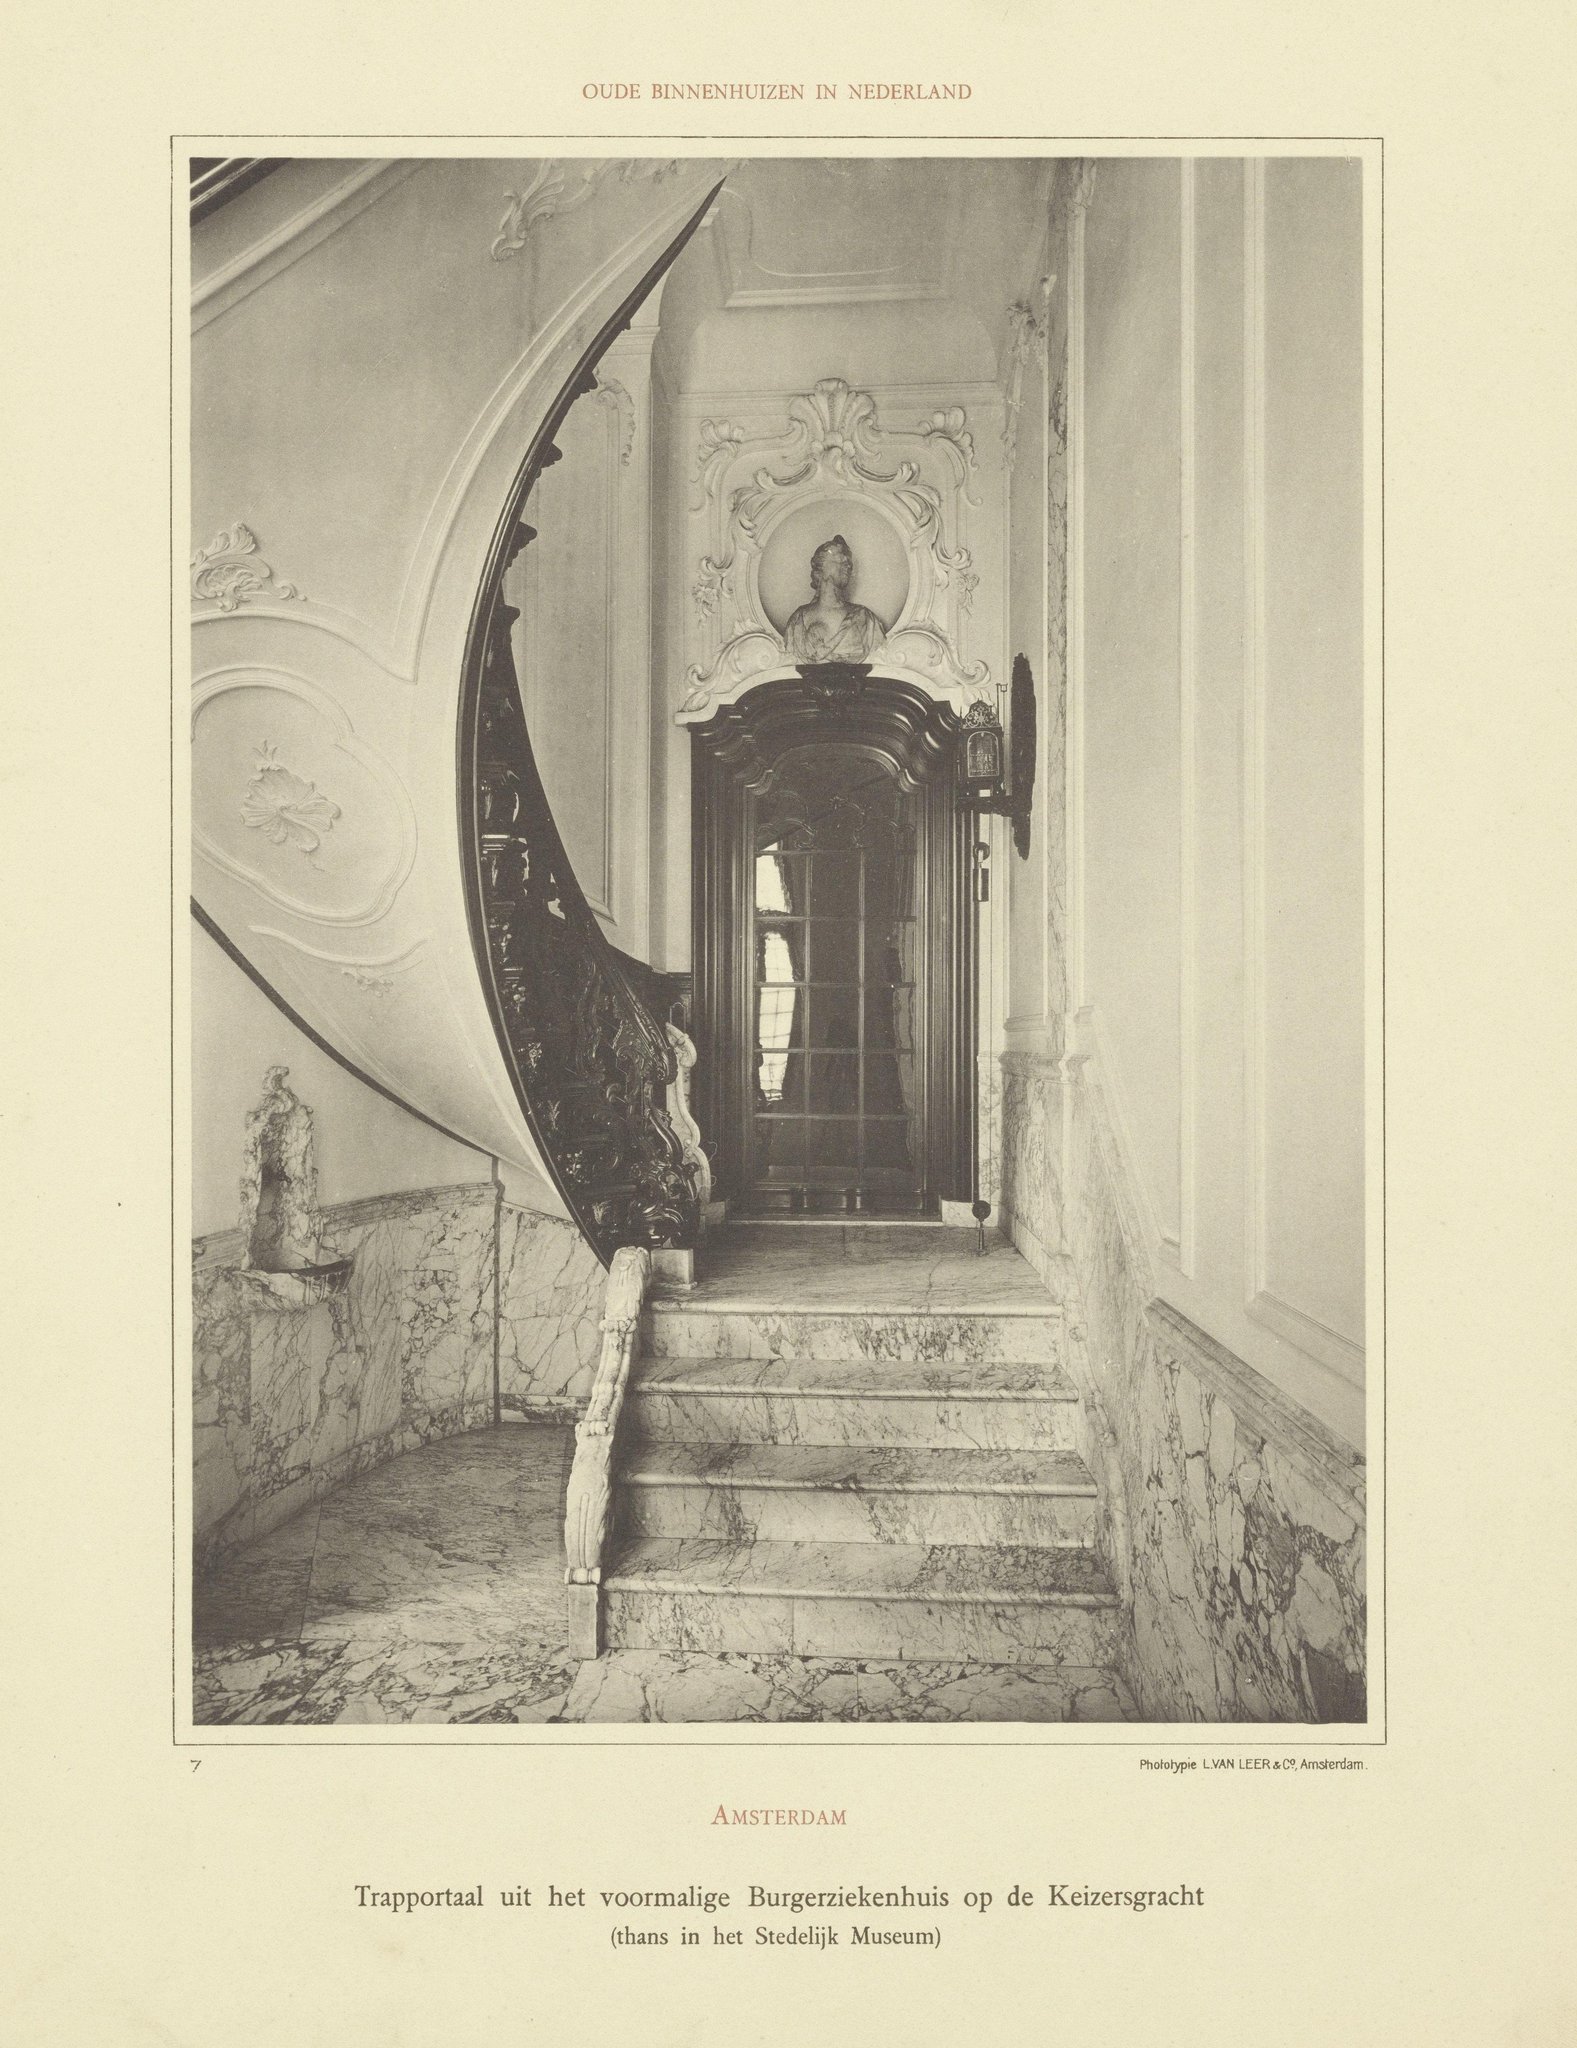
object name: spiral stair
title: Onderdelen van het trapportaal uit het pand aan de Keizersgracht 187 te Amsterdam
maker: Anonymous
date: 1740-1760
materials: wood, marble